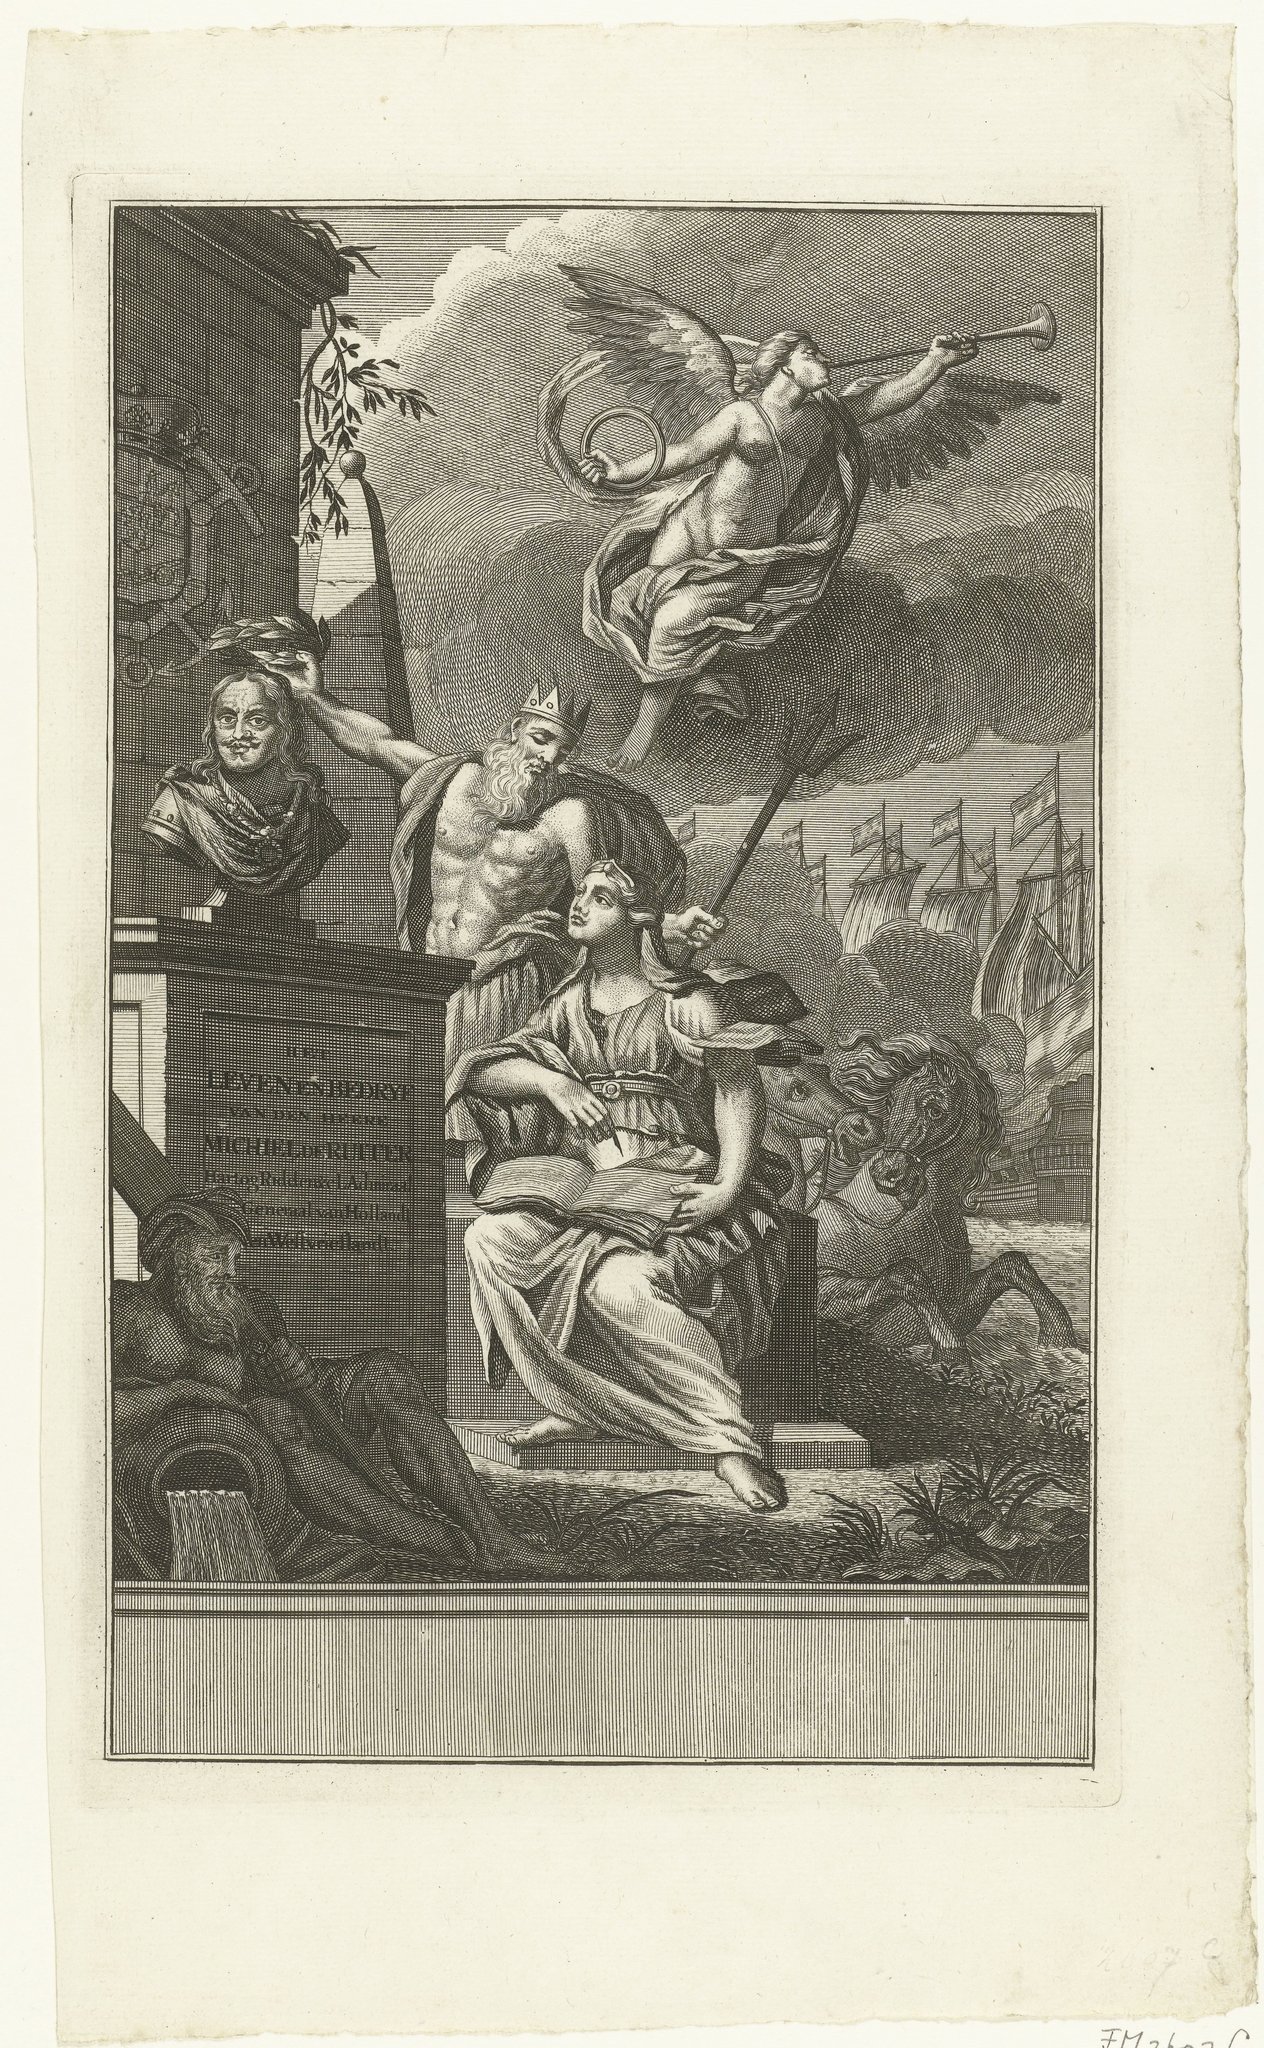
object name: titelblad, titelpagina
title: Titelpagina voor: G. Brandt, Het leven en bedryf van den heere Michiel de Ruiter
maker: Anonymous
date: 1677-1749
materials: paper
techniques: engraving, etching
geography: northern netherlands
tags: flushing, michiel adriaenszoon de ruyter, title-page, 'historia'; 'historia' (ripa), fame; 'fama', 'fama buona', 'fama chiara' (ripa)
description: Titelpagina voor een uitgave van: G. Brandt, Het leven en bedryf van den heere Michiel de Ruiter. Allegorische titelpagina met Neptunus, Geschiedenis en Faam bij een monument voor Michiel Adriaenszoon de Ruyter.